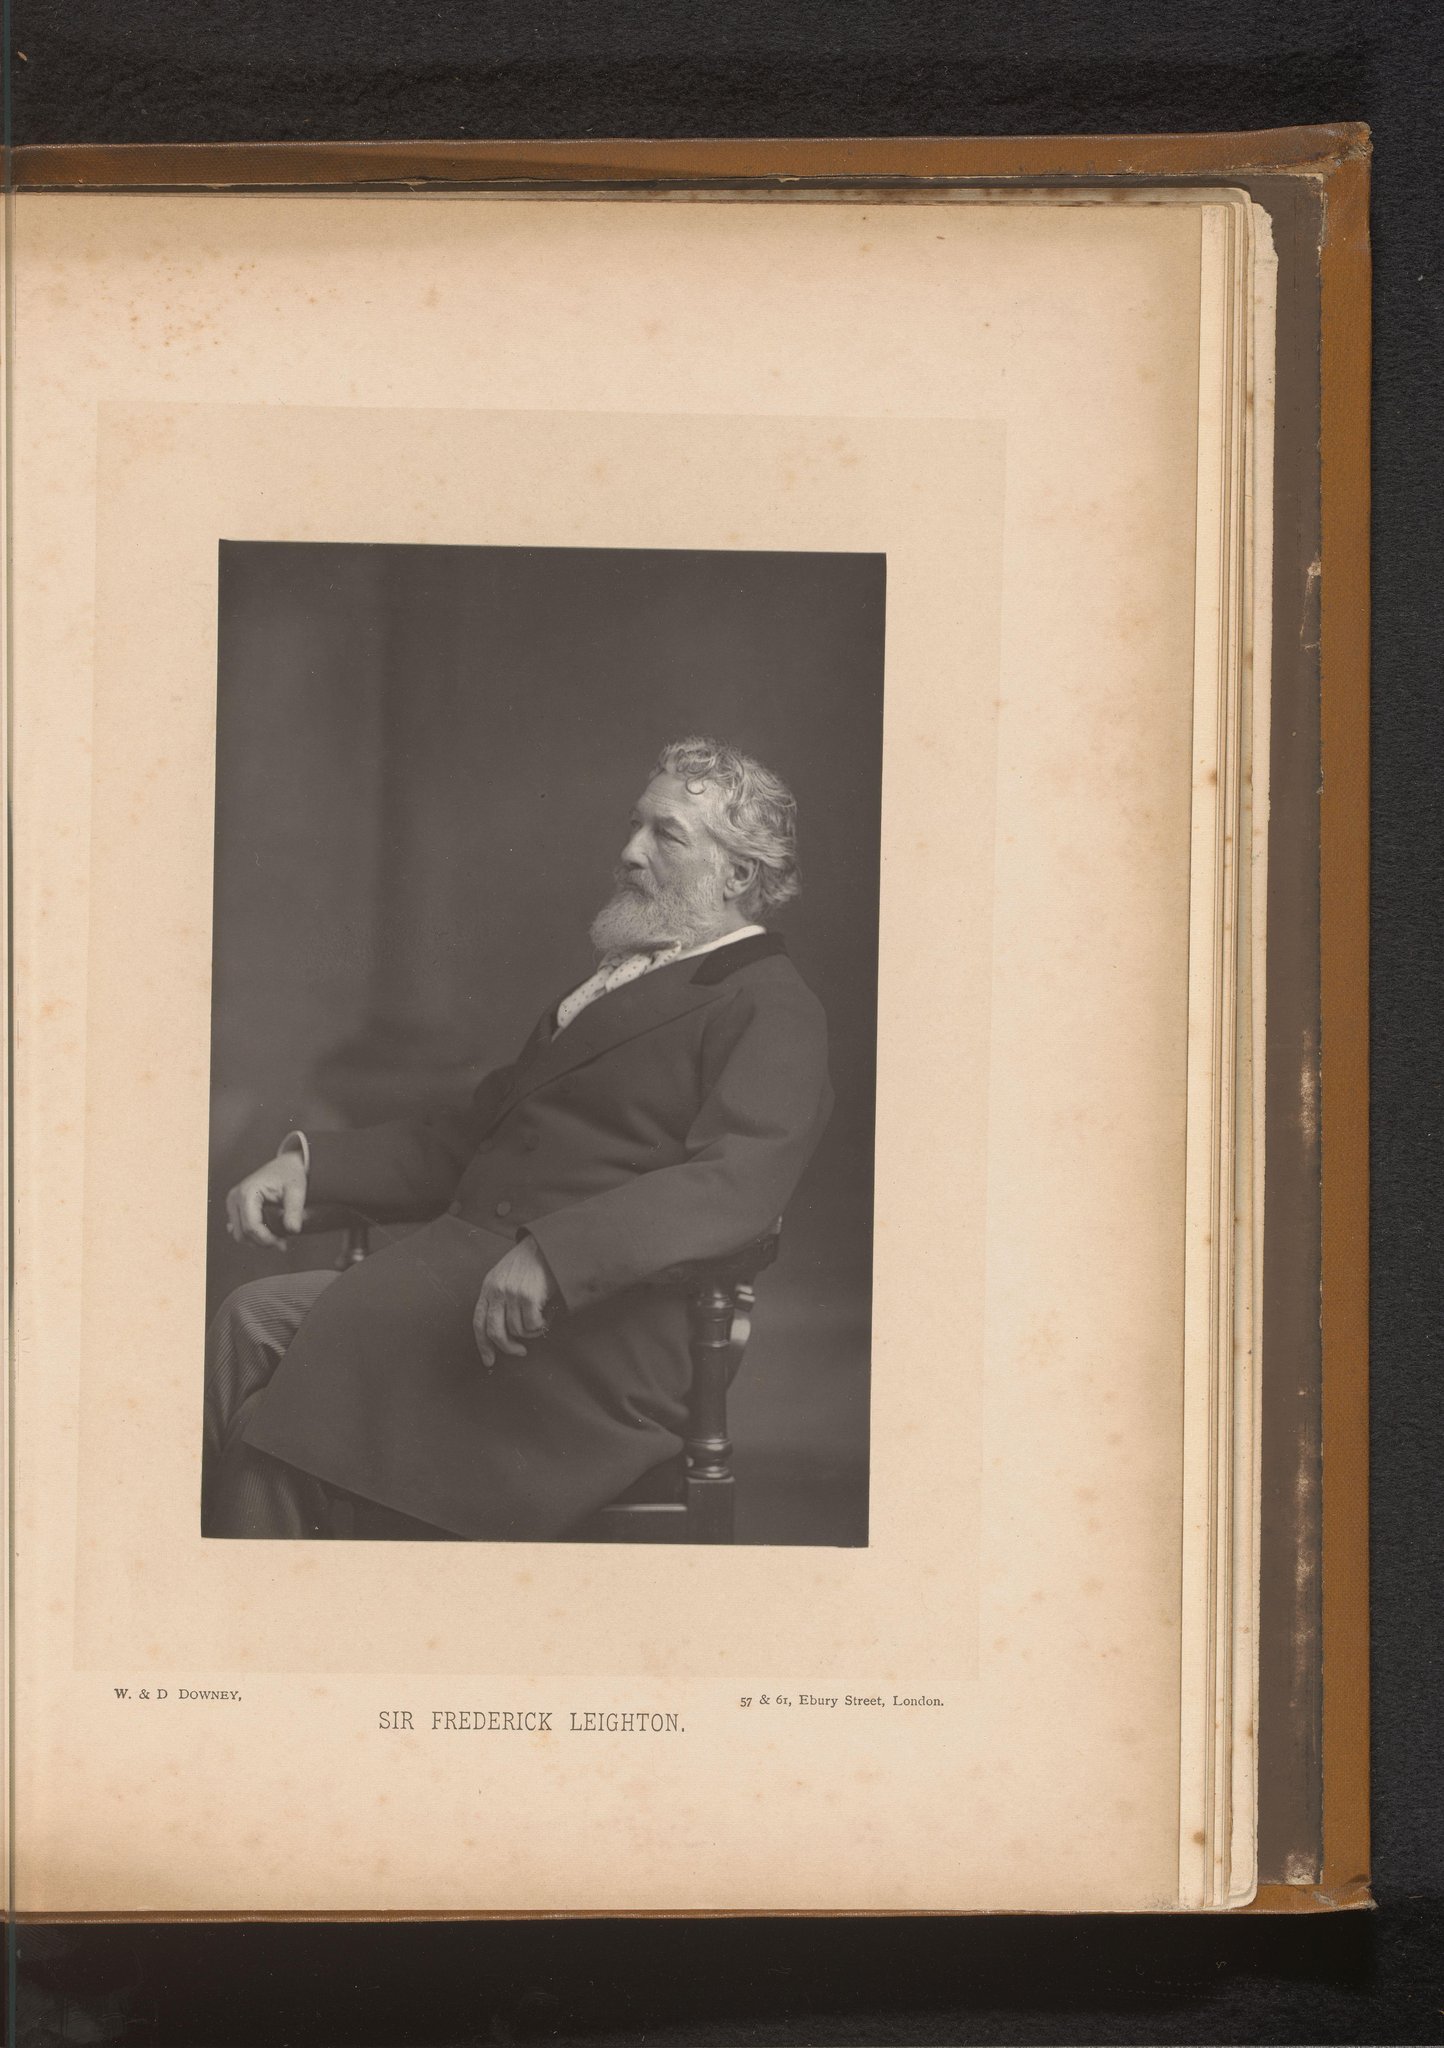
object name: page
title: Portret van Frederic Leighton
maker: Anonymous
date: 1880-1890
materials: paper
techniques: woodburytype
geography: london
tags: london, painter, draughtsman, sculptor, frederick leighton, portrait, self-portrait of painter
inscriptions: inscription: ‘57 & 61, Elbury Street, London.’